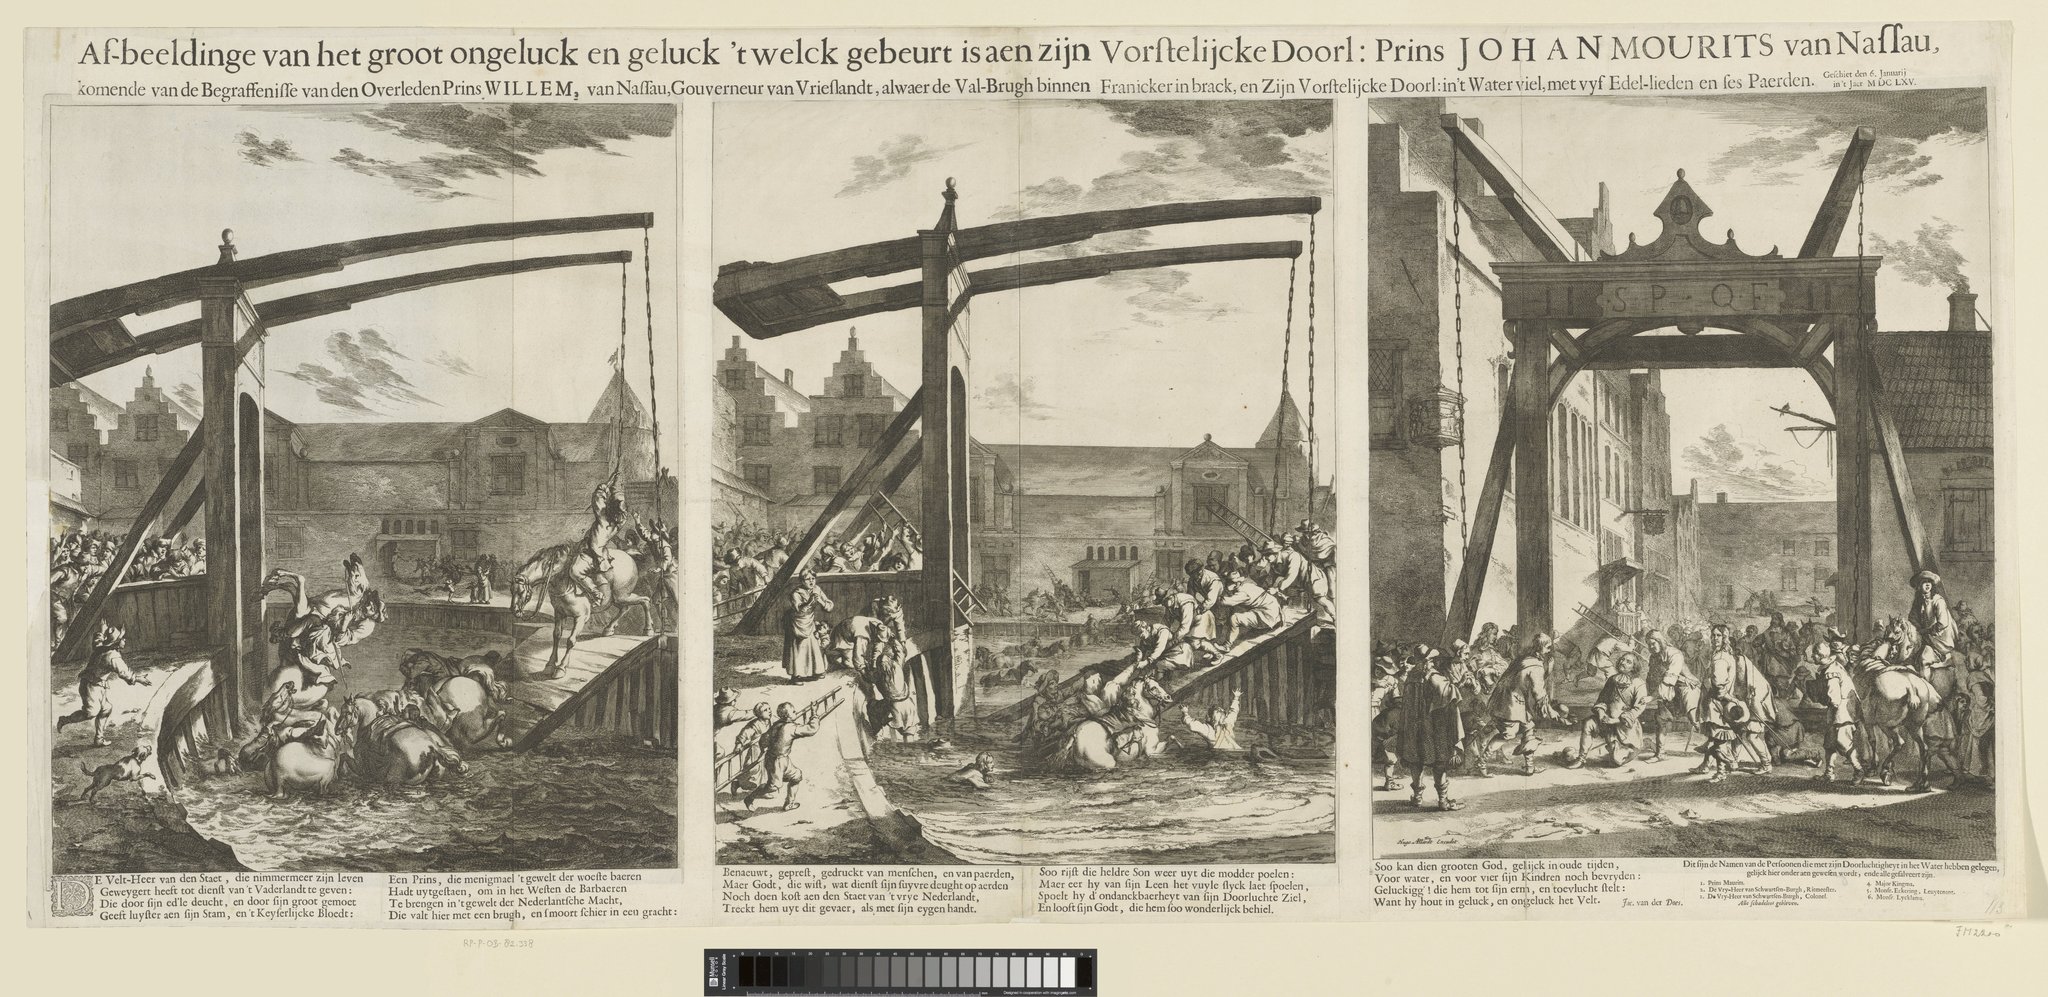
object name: print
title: Af-beeldinge van het groot ongeluck en geluck 't welck gebeurt is aen zijn Vorstelijcke Doorl: Prins Johan Mourits van Nassau, komende van de Begraffenisse van den Overleden Prins Willem (...) alwaer de Val-Brugh binnen Franicker in brack, en Zijn Vorstelijcke Doorl: in 't Water viel, met vyf Edel-lieden en ses Paerden. Geschiet den 6. Januarij in 't Jaer MDCLXV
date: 1665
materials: paper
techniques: etching, letterpress printing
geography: northern netherlands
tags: earl, johan maurits graaf van nassau-siegen, collapsing building, bridge, accident with horse (or kindred animal), saving a person from drowning, one person praying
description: Groot blad samengesteld uit de drie opeenvolgende voorstellingen van het ongeluk van graaf Johan Maurits bij de brug te Franeker, 6 januari 1665. Links met instorten van de ophaalbrug waar de graaf met zijn gevolg overheen rijdt en de val van de graaf in het water. Centraal de redding van graaf Johan Maurits, de graaf wordt uit het water gehaald, omstanders komen met ladders aangesneld. Rechts de dankzegging door graaf Johan Maurits na zijn redding na het ongeluk. De graaf knielt bij de ingestorte ophaalbrug. Onderaan het gedicht in 5 vierregelige verzen en een lijst van de personen 1-6.